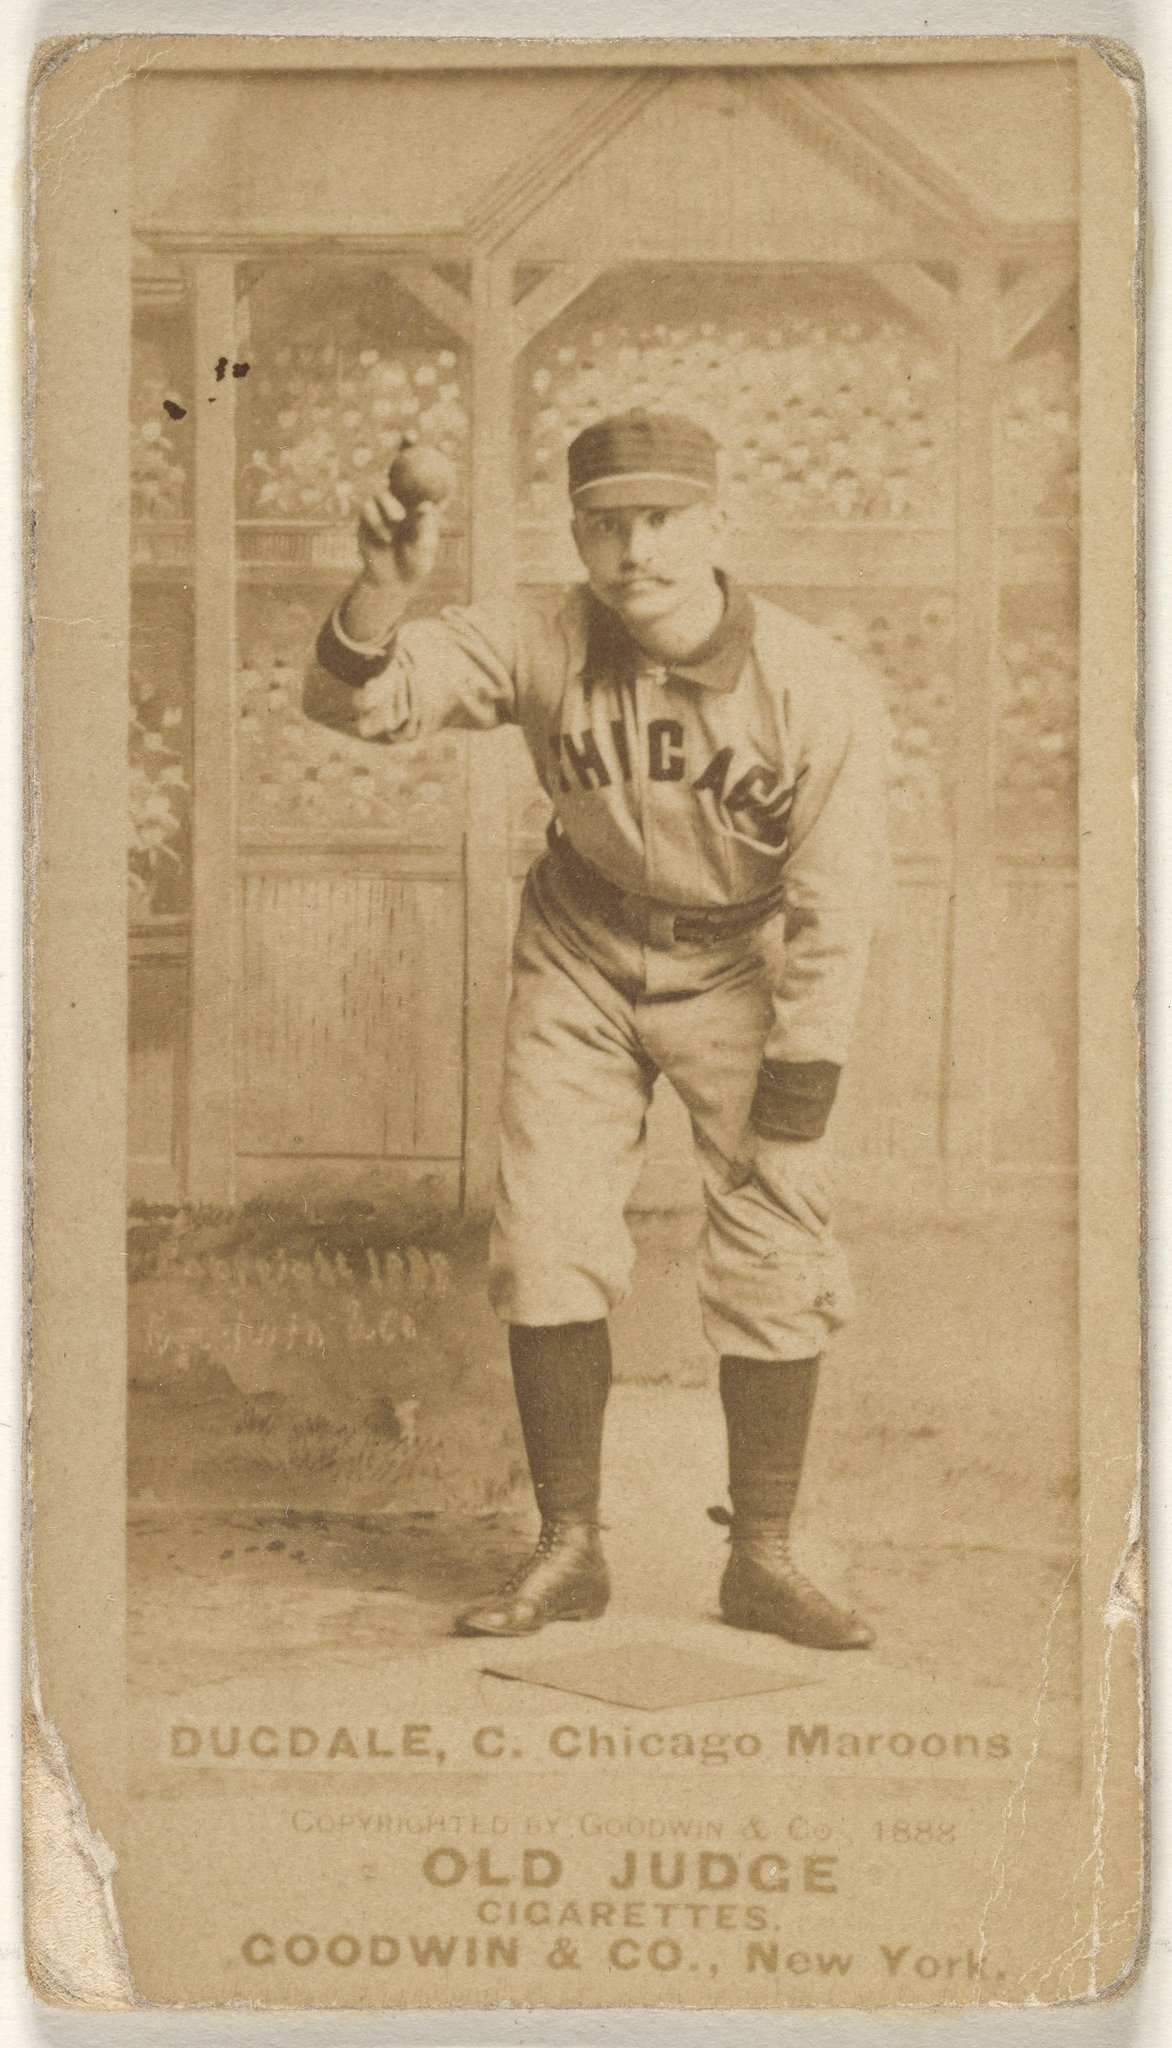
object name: baseball card, photograph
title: Dan Dugdale, Catcher, Chicago, from the Old Judge series (N172) for Old Judge Cigarettes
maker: goodwin & company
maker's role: publisher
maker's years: 1850-1950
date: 1888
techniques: albumen silver print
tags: men,portraits,baseball,athletes